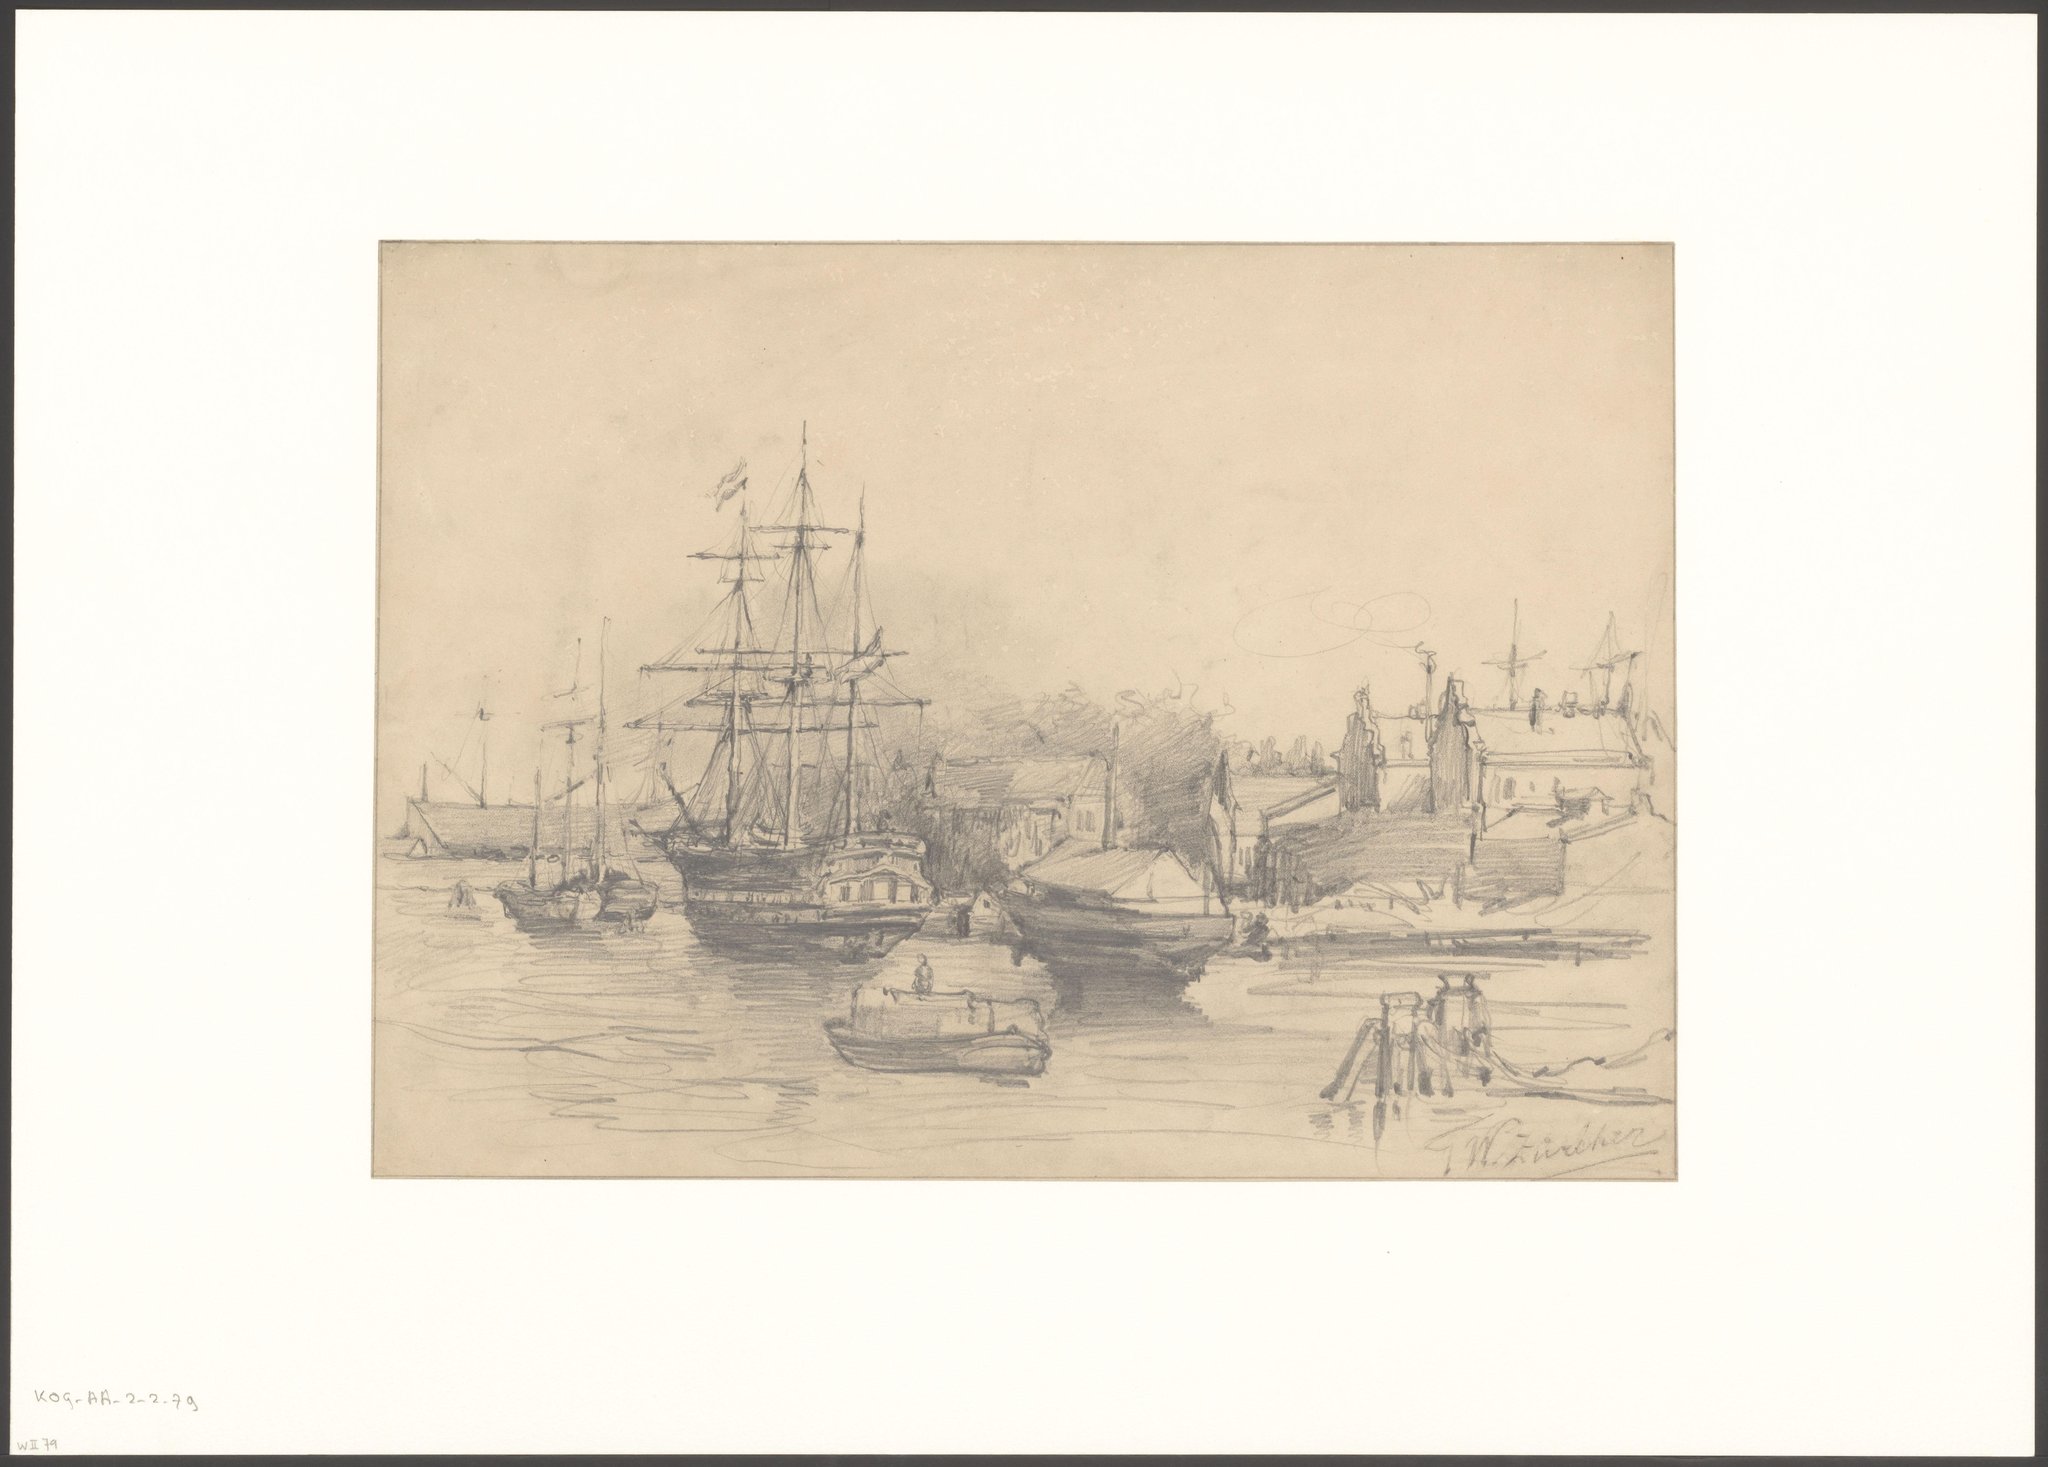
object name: drawing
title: Gezicht op de Westerdok en scheepswerf De Nachtegaal aan de Grote Bickersstraat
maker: frederik willem zürcher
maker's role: draughtsman, print maker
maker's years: 1835-1894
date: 1845-1894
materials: paper, pencil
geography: amsterdam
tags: sailing-ship, sailing-boat, city-view in general; 'veduta', river, pier, quay, wharf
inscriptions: signature: ‘FW. Zürcher’, collector's mark: Lugt 800a, inscription: ‘Westerdok: Amsterdam / bij werf de Nachtegaal’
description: Tekening binnen de Atlas Van Eck ingedeeld op wijknummer 2.